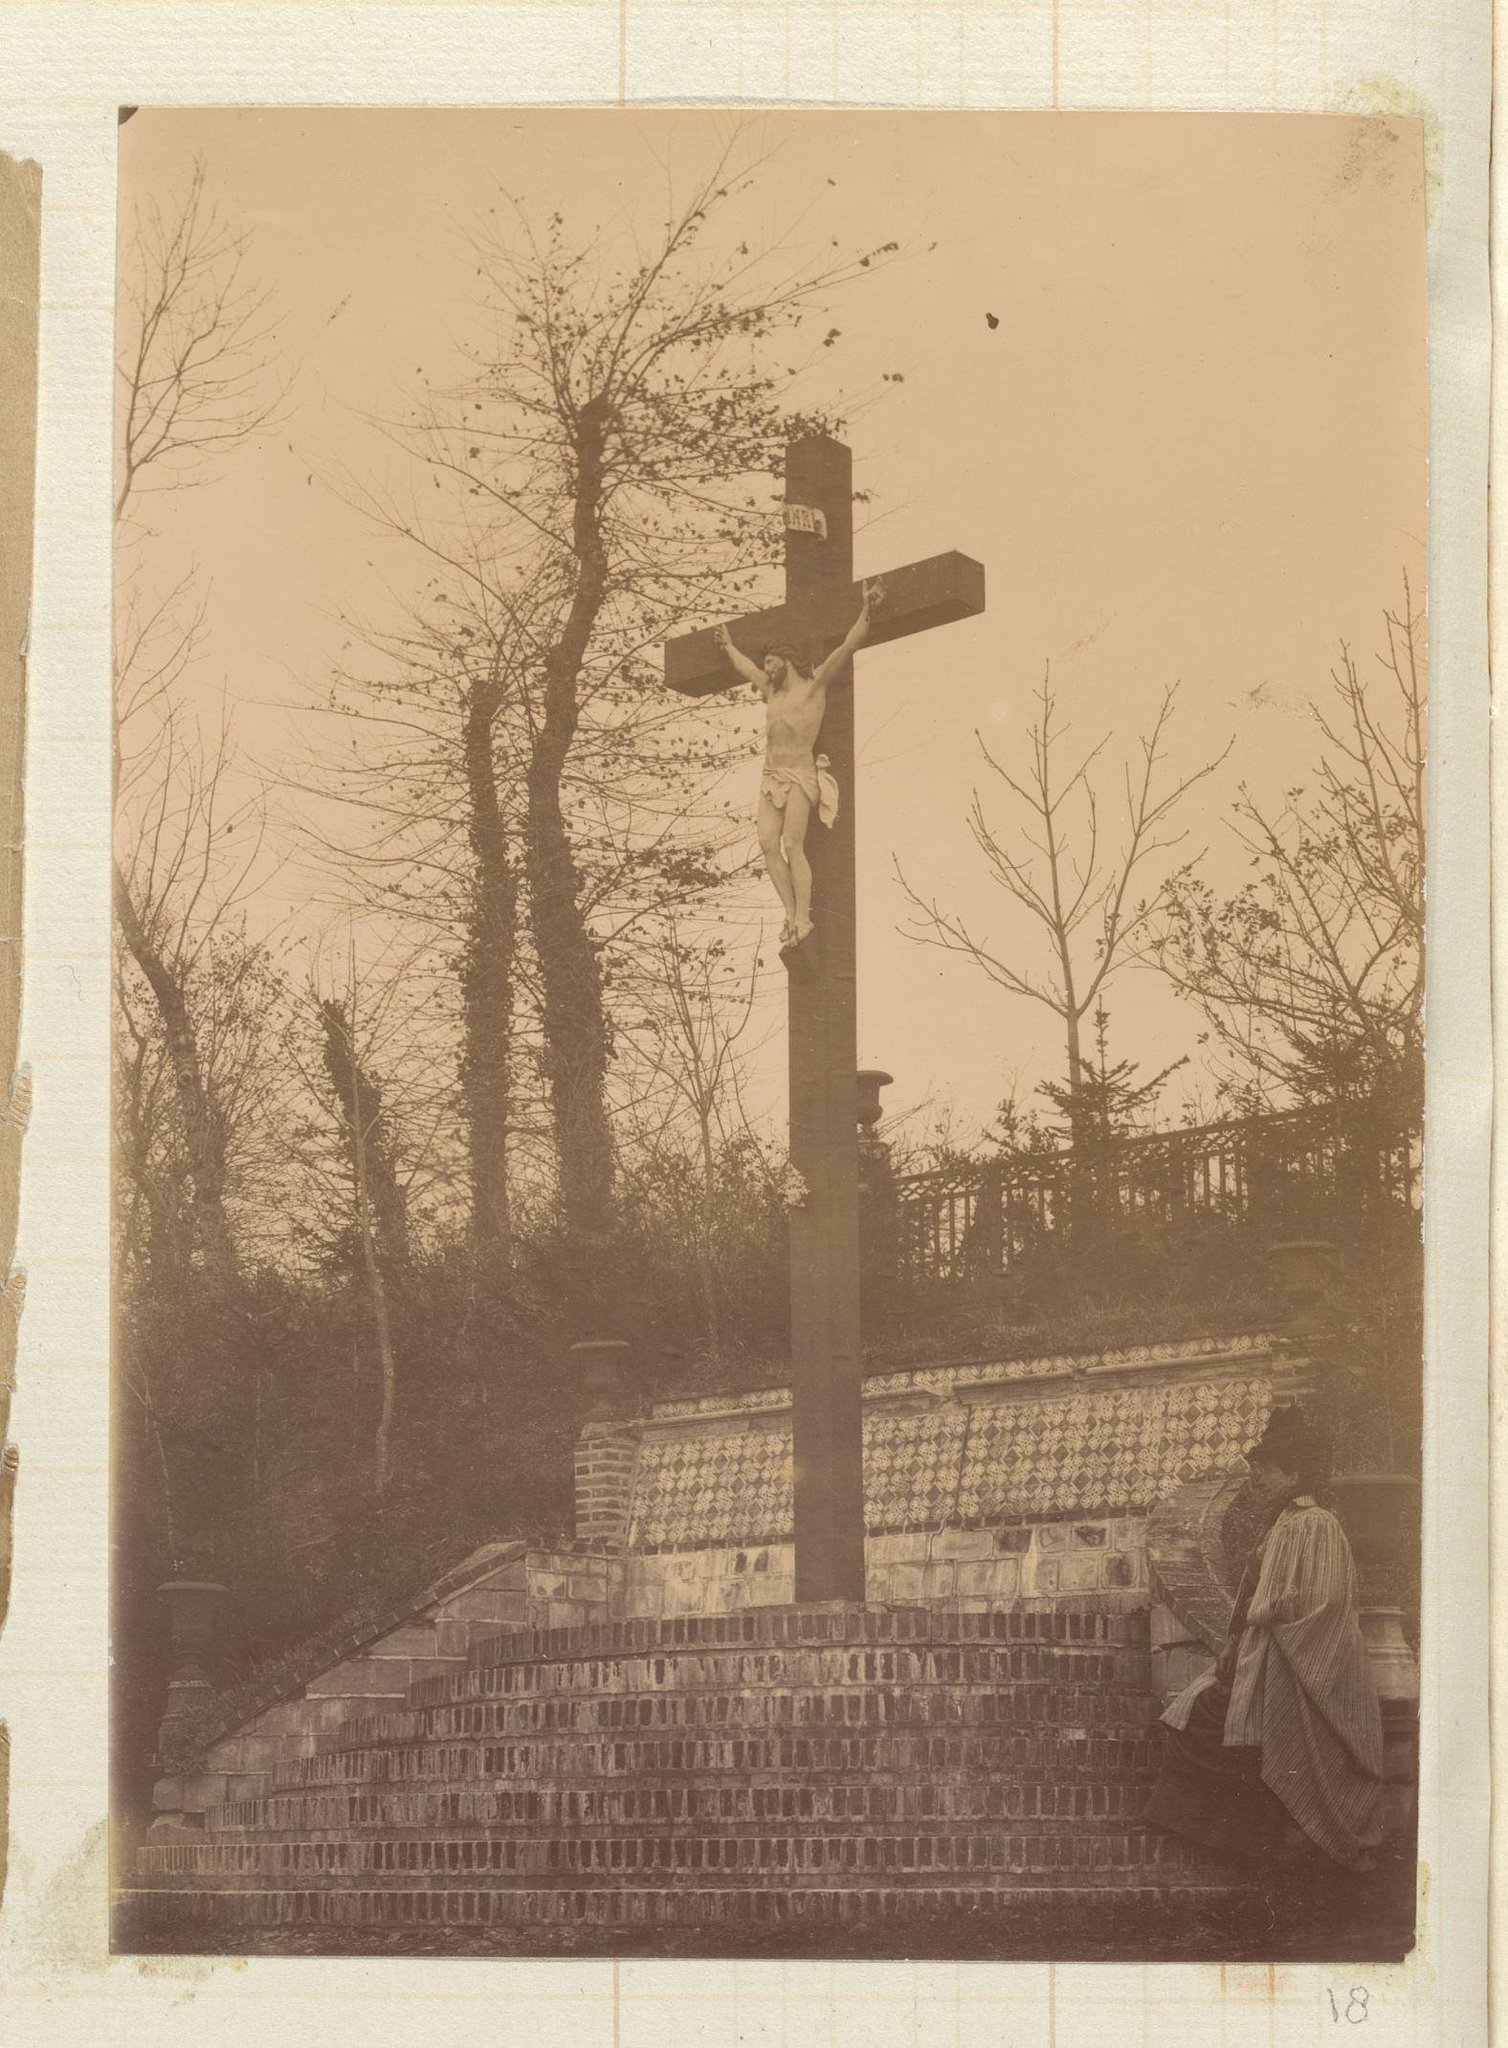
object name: photograph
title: Vrouw in lange mantel aan de voet van een kruisbeeld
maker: Anonymous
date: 1880-1900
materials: paper, photographic support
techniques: gelatin silver print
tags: altarcross, crucifix